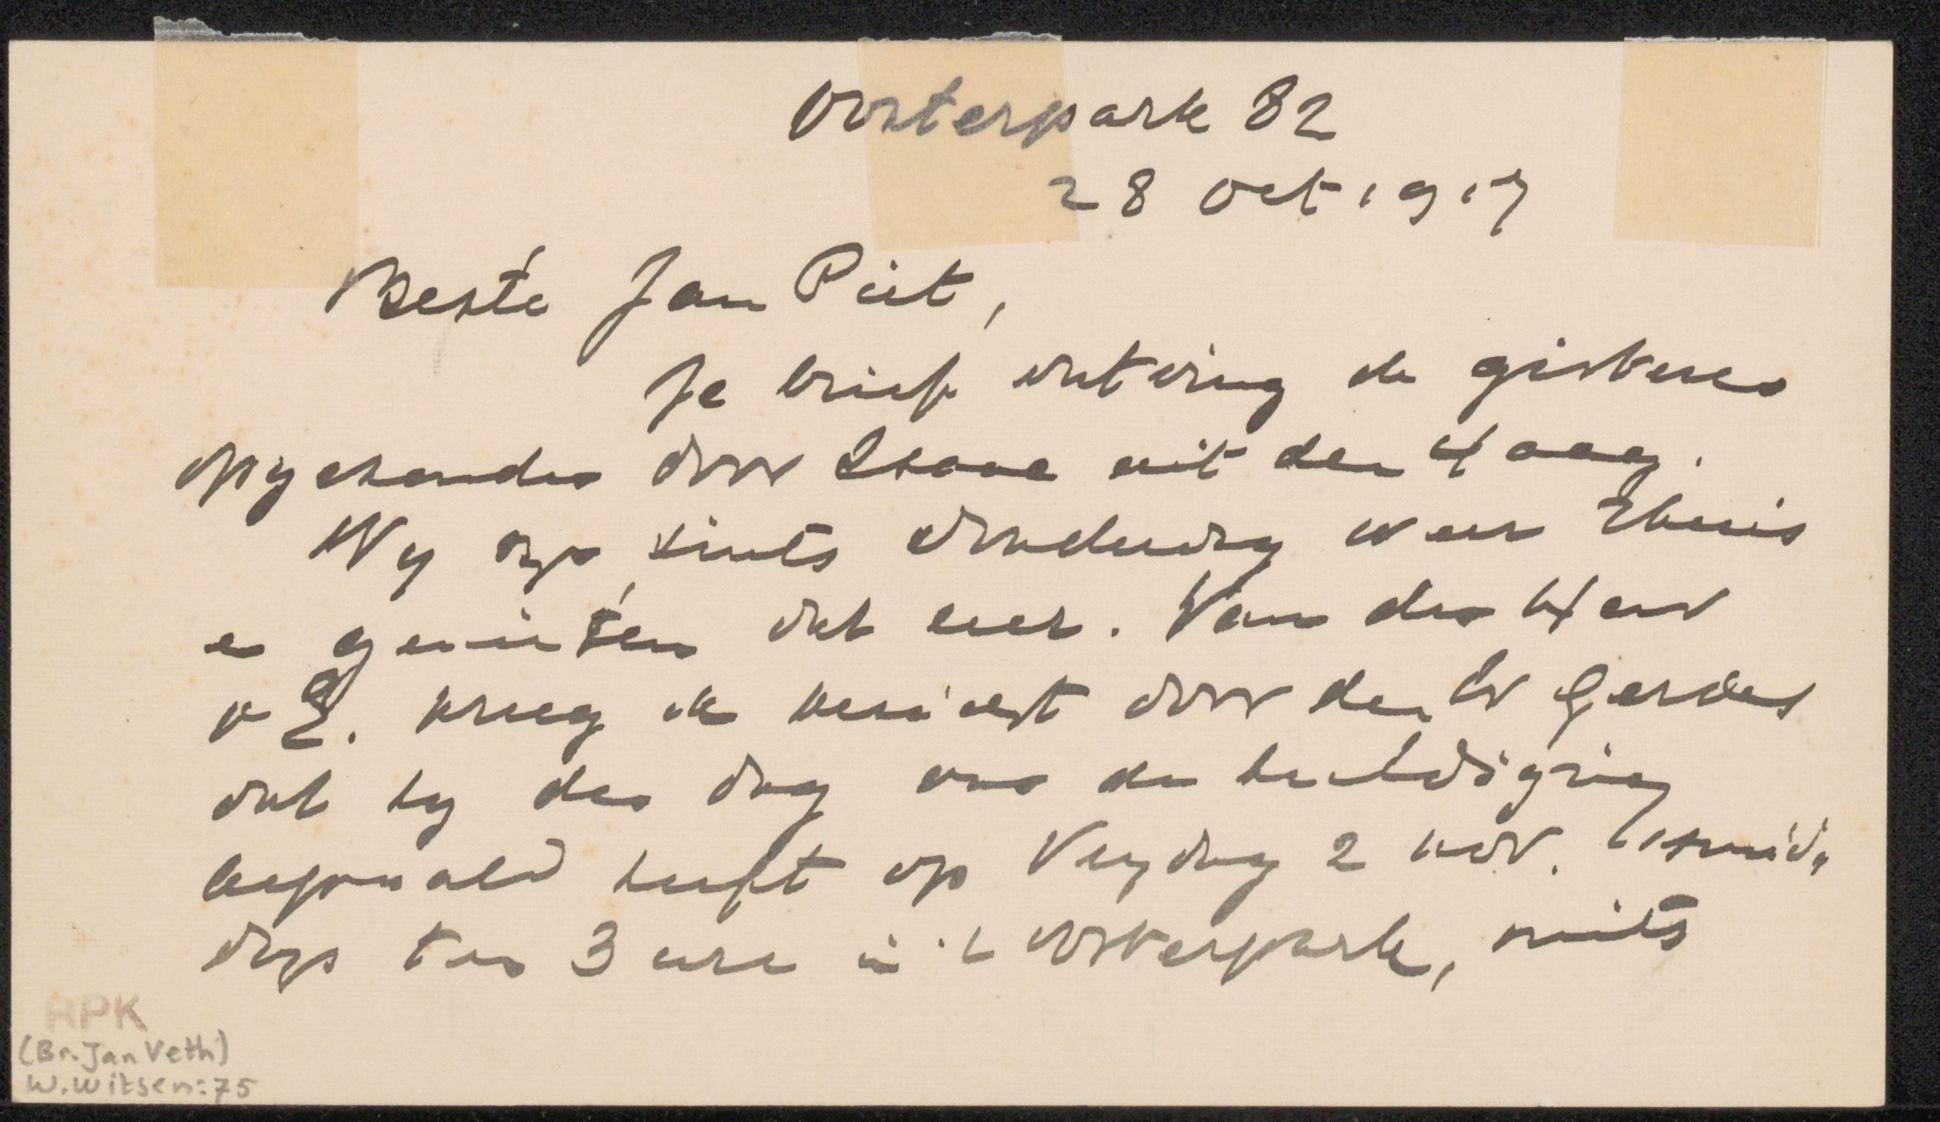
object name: letter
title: Brief aan Jan Veth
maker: willem witsen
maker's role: draughtsman, painter, print maker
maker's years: 1860-1923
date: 1917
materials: cardboard, ink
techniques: pen, writing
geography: amsterdam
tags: george hendrik breitner, dordrecht, jan veth, amsterdam, the hague, painter, print maker, draughtsman, isaac israels, ed gerdes, diseases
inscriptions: collector's mark: ‘RPK’